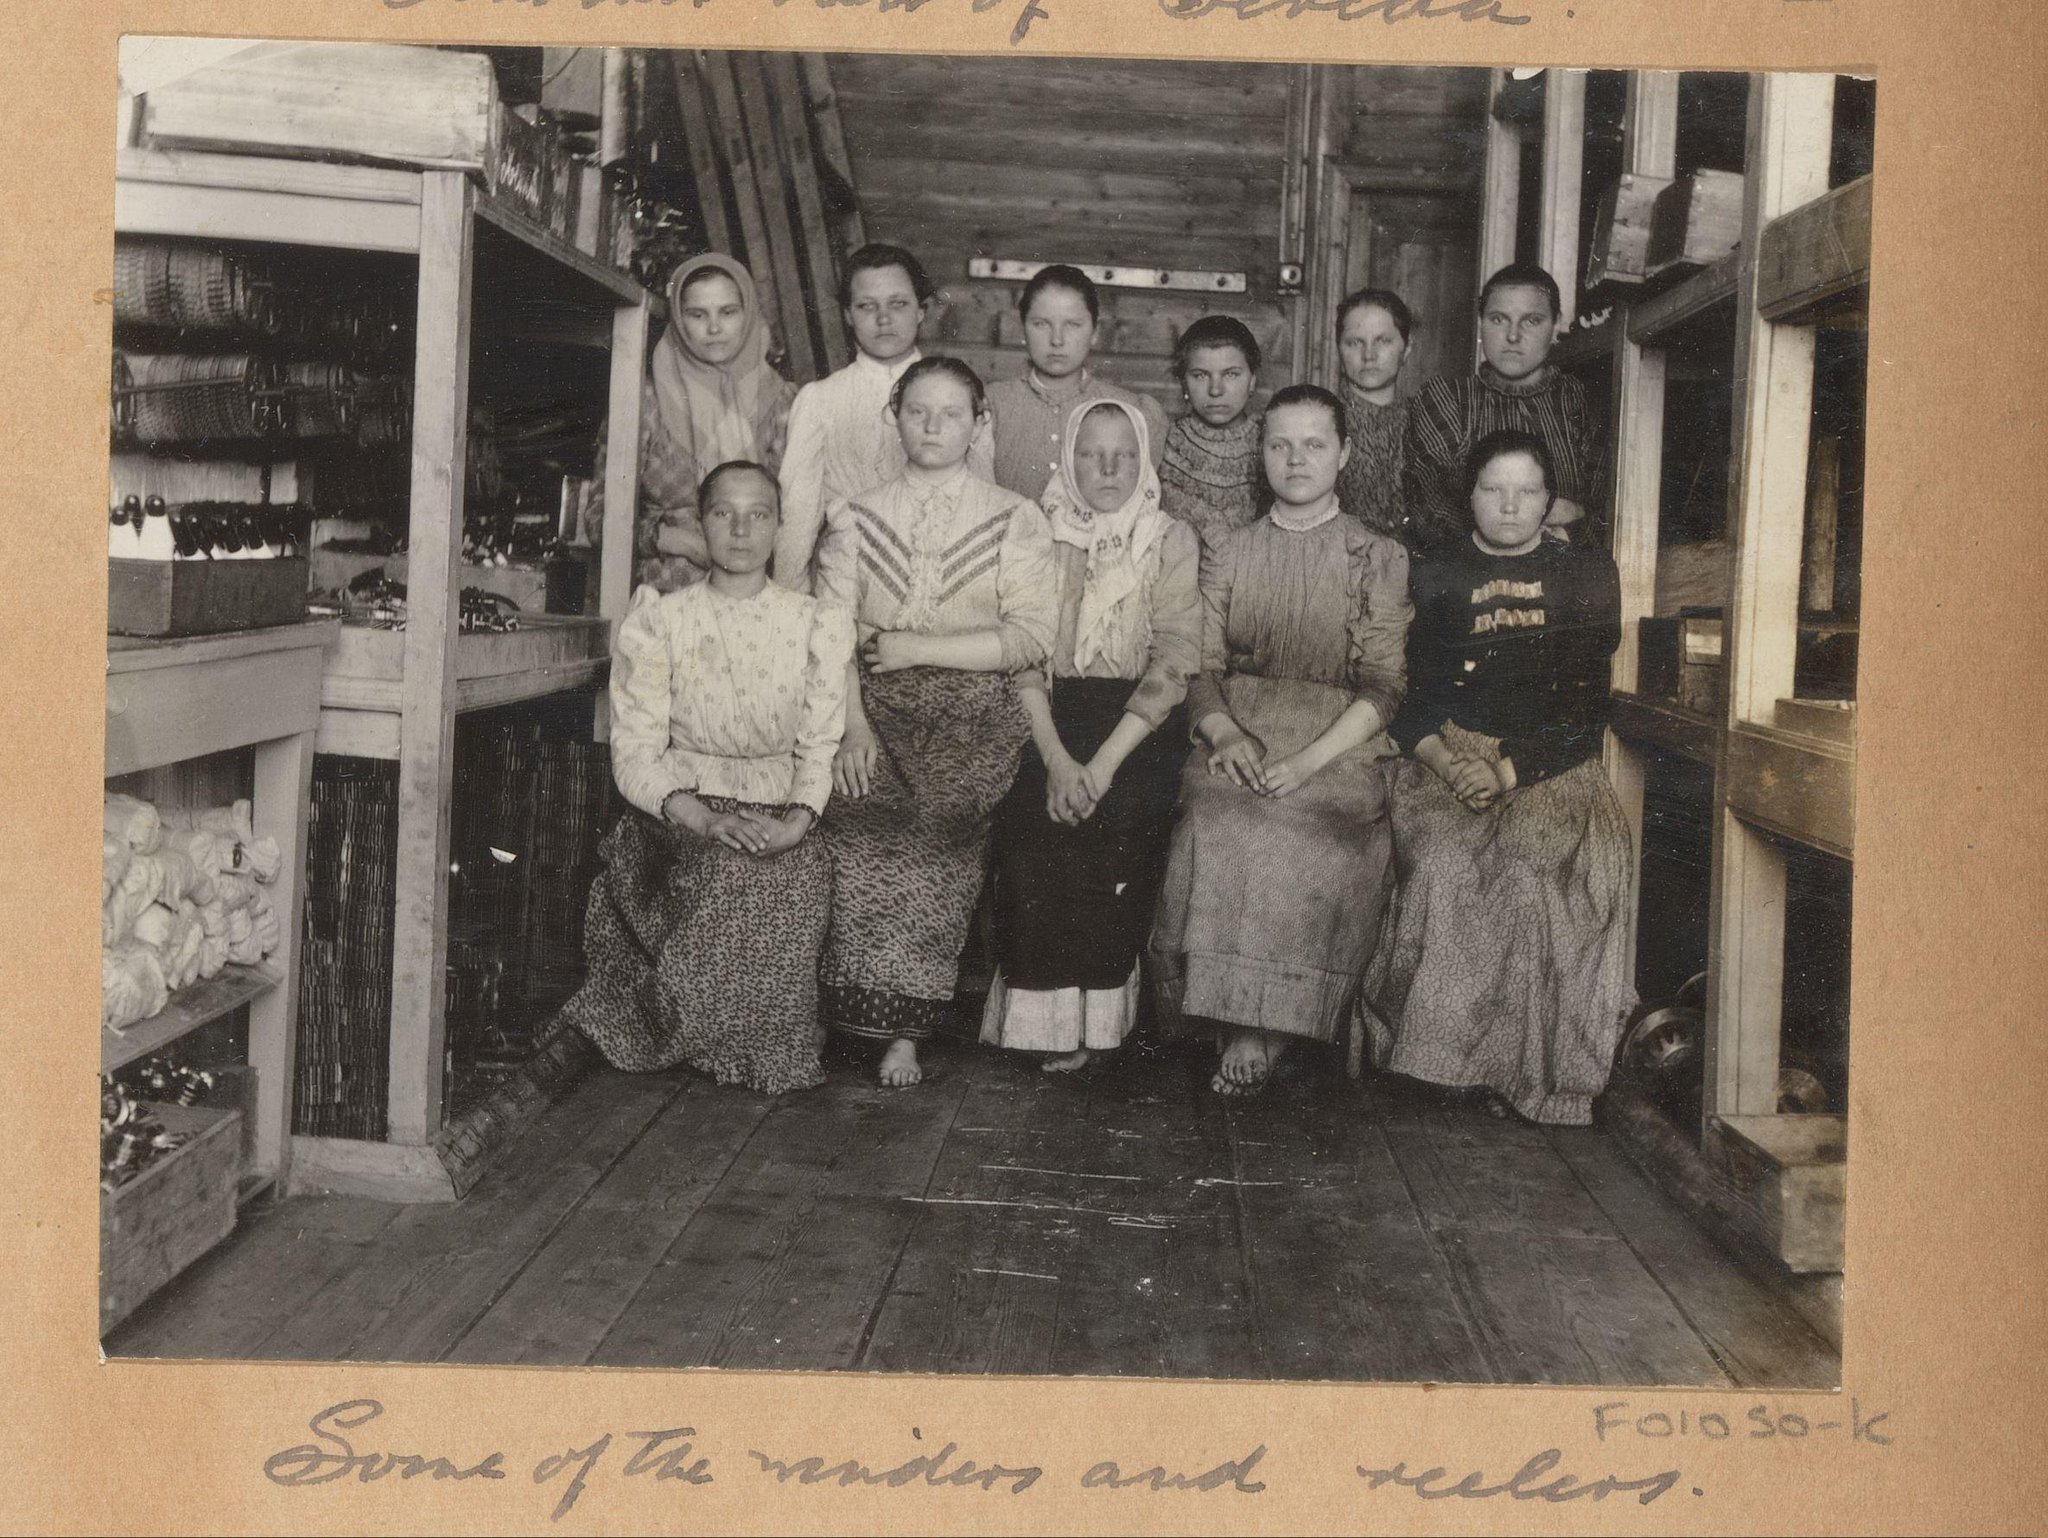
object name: photograph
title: Fabrieksarbeidsters te Sereda in Rusland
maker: joseph cheetham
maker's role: engineer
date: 1903-1904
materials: photographic support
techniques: gelatin silver print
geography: russia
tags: factory-interior, machine shop, barefoot, working class, labourers - aa - women, russia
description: Onderdeel van Fotoalbum van de Engelse familie Cheetham met opnames van hun verblijf in Rusland.